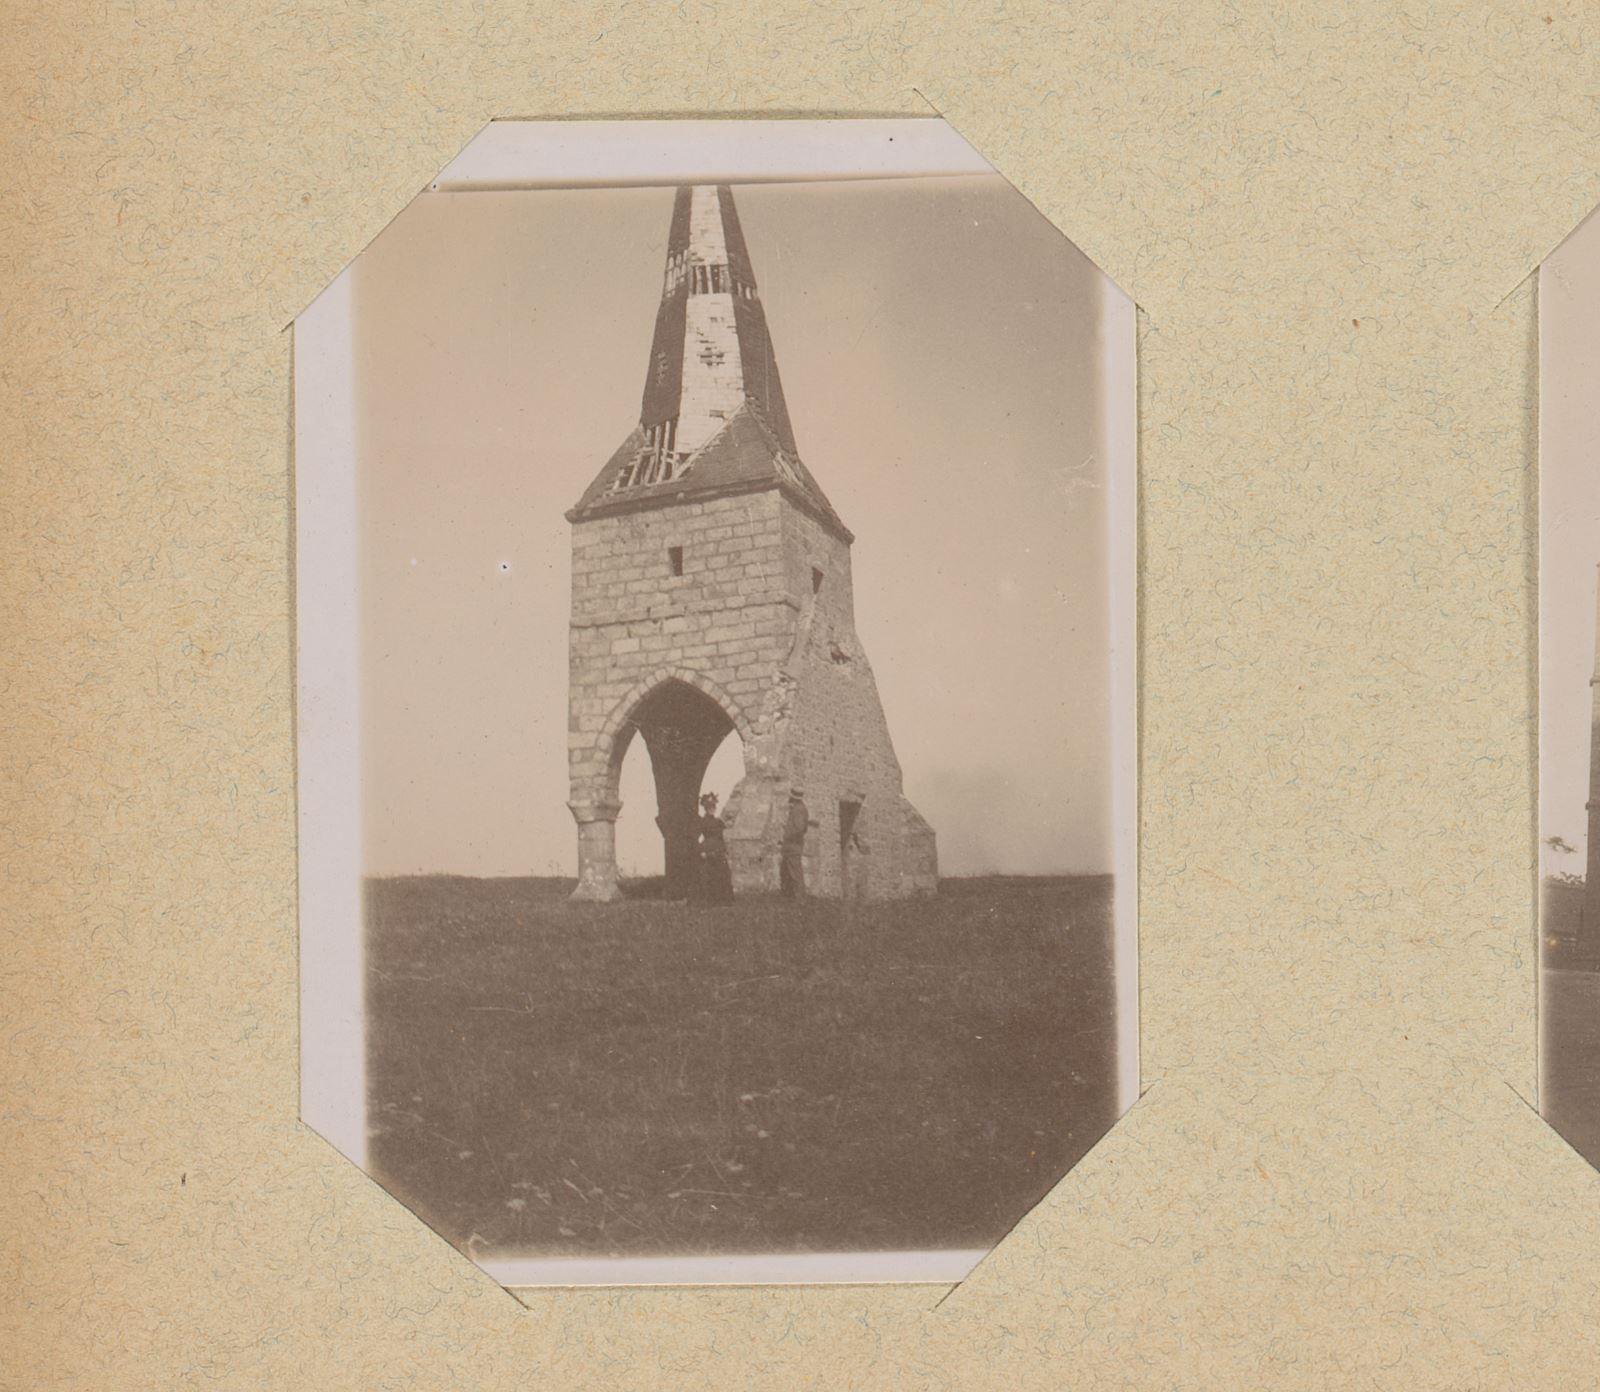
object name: photograph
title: Twee mensen bij vervallen kerk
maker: Anonymous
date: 1895-1900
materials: paper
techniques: gelatin silver print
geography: france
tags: ruin of church, monastery, etc., france